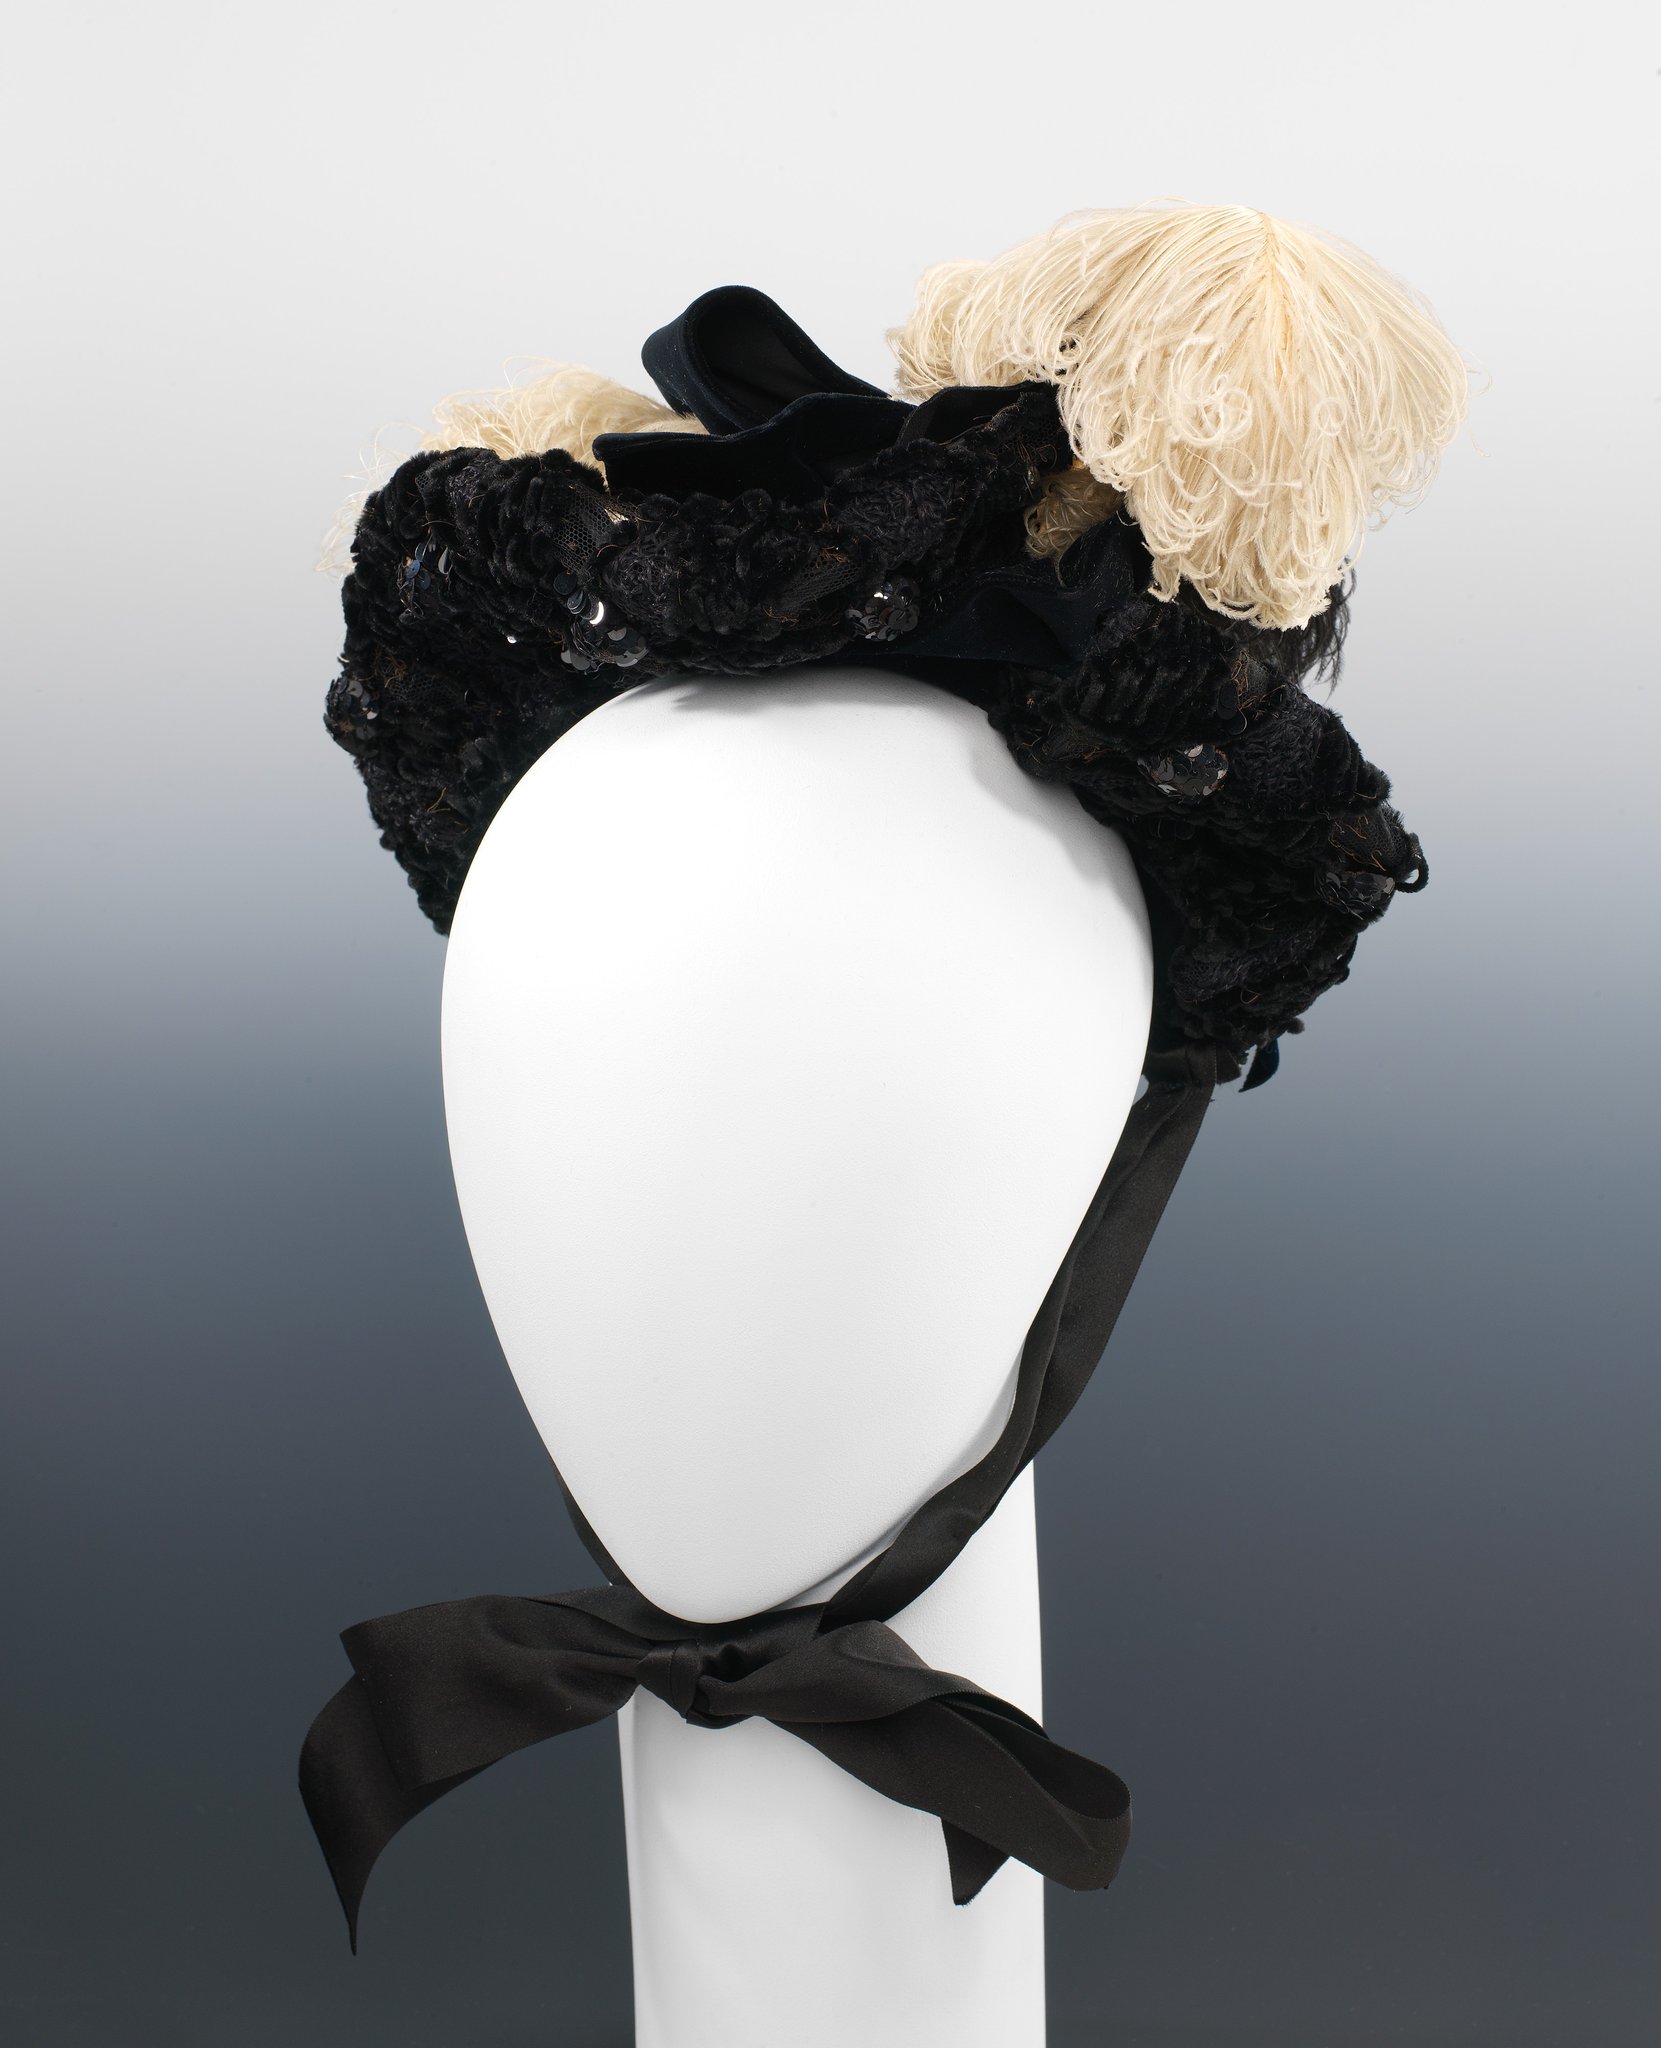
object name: evening bonnet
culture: french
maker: mangin maurice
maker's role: designer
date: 1885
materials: feather, metal, silk